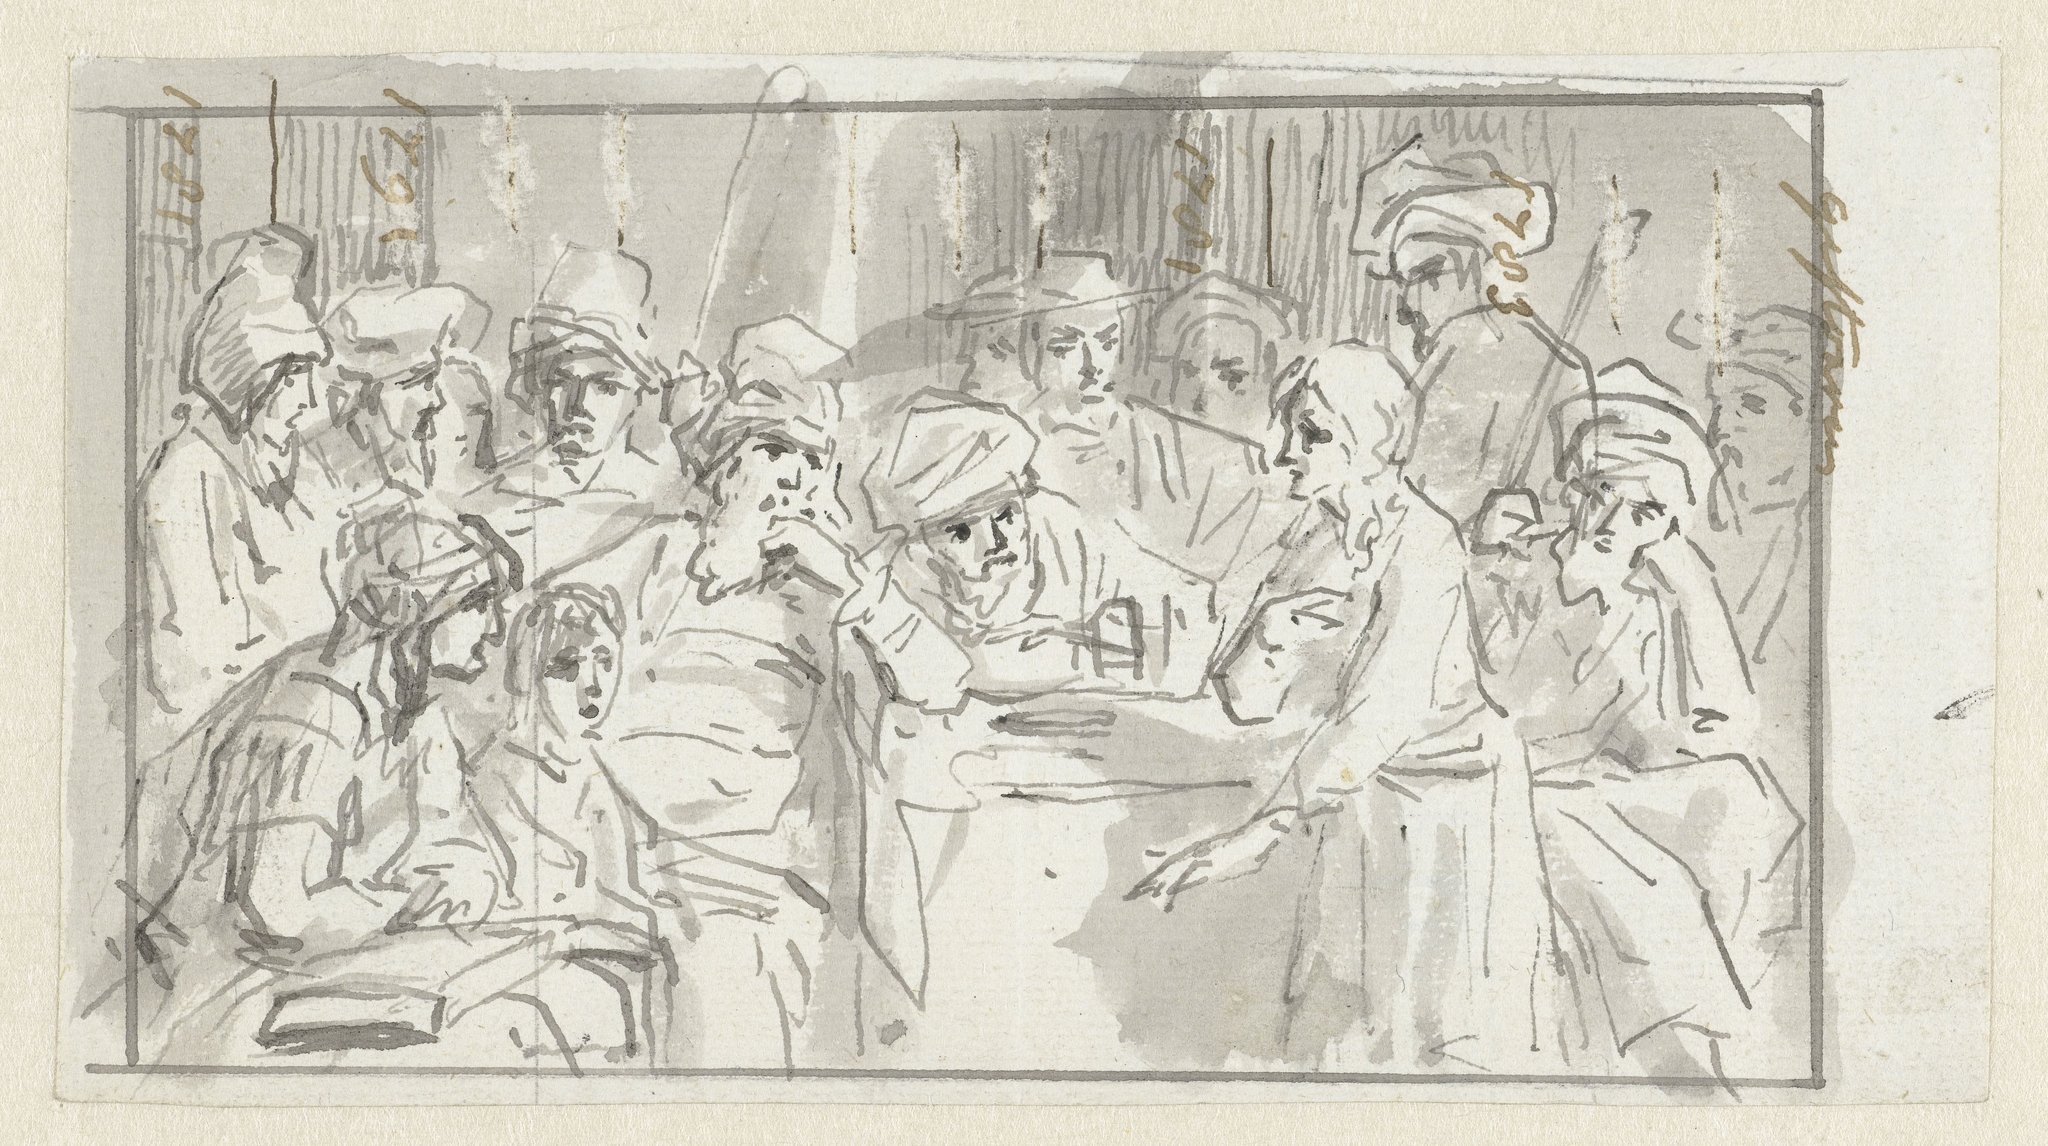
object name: drawing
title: Schets van Christus tussen de schriftgeleerden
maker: jurriaan andriessen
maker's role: draughtsman, painter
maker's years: 1742-1819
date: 1752-1819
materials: graphite, ink, paper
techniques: brush, pen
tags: christ's dispute with the doctors in the temple; he counts his arguments on his fingers, picture, painting